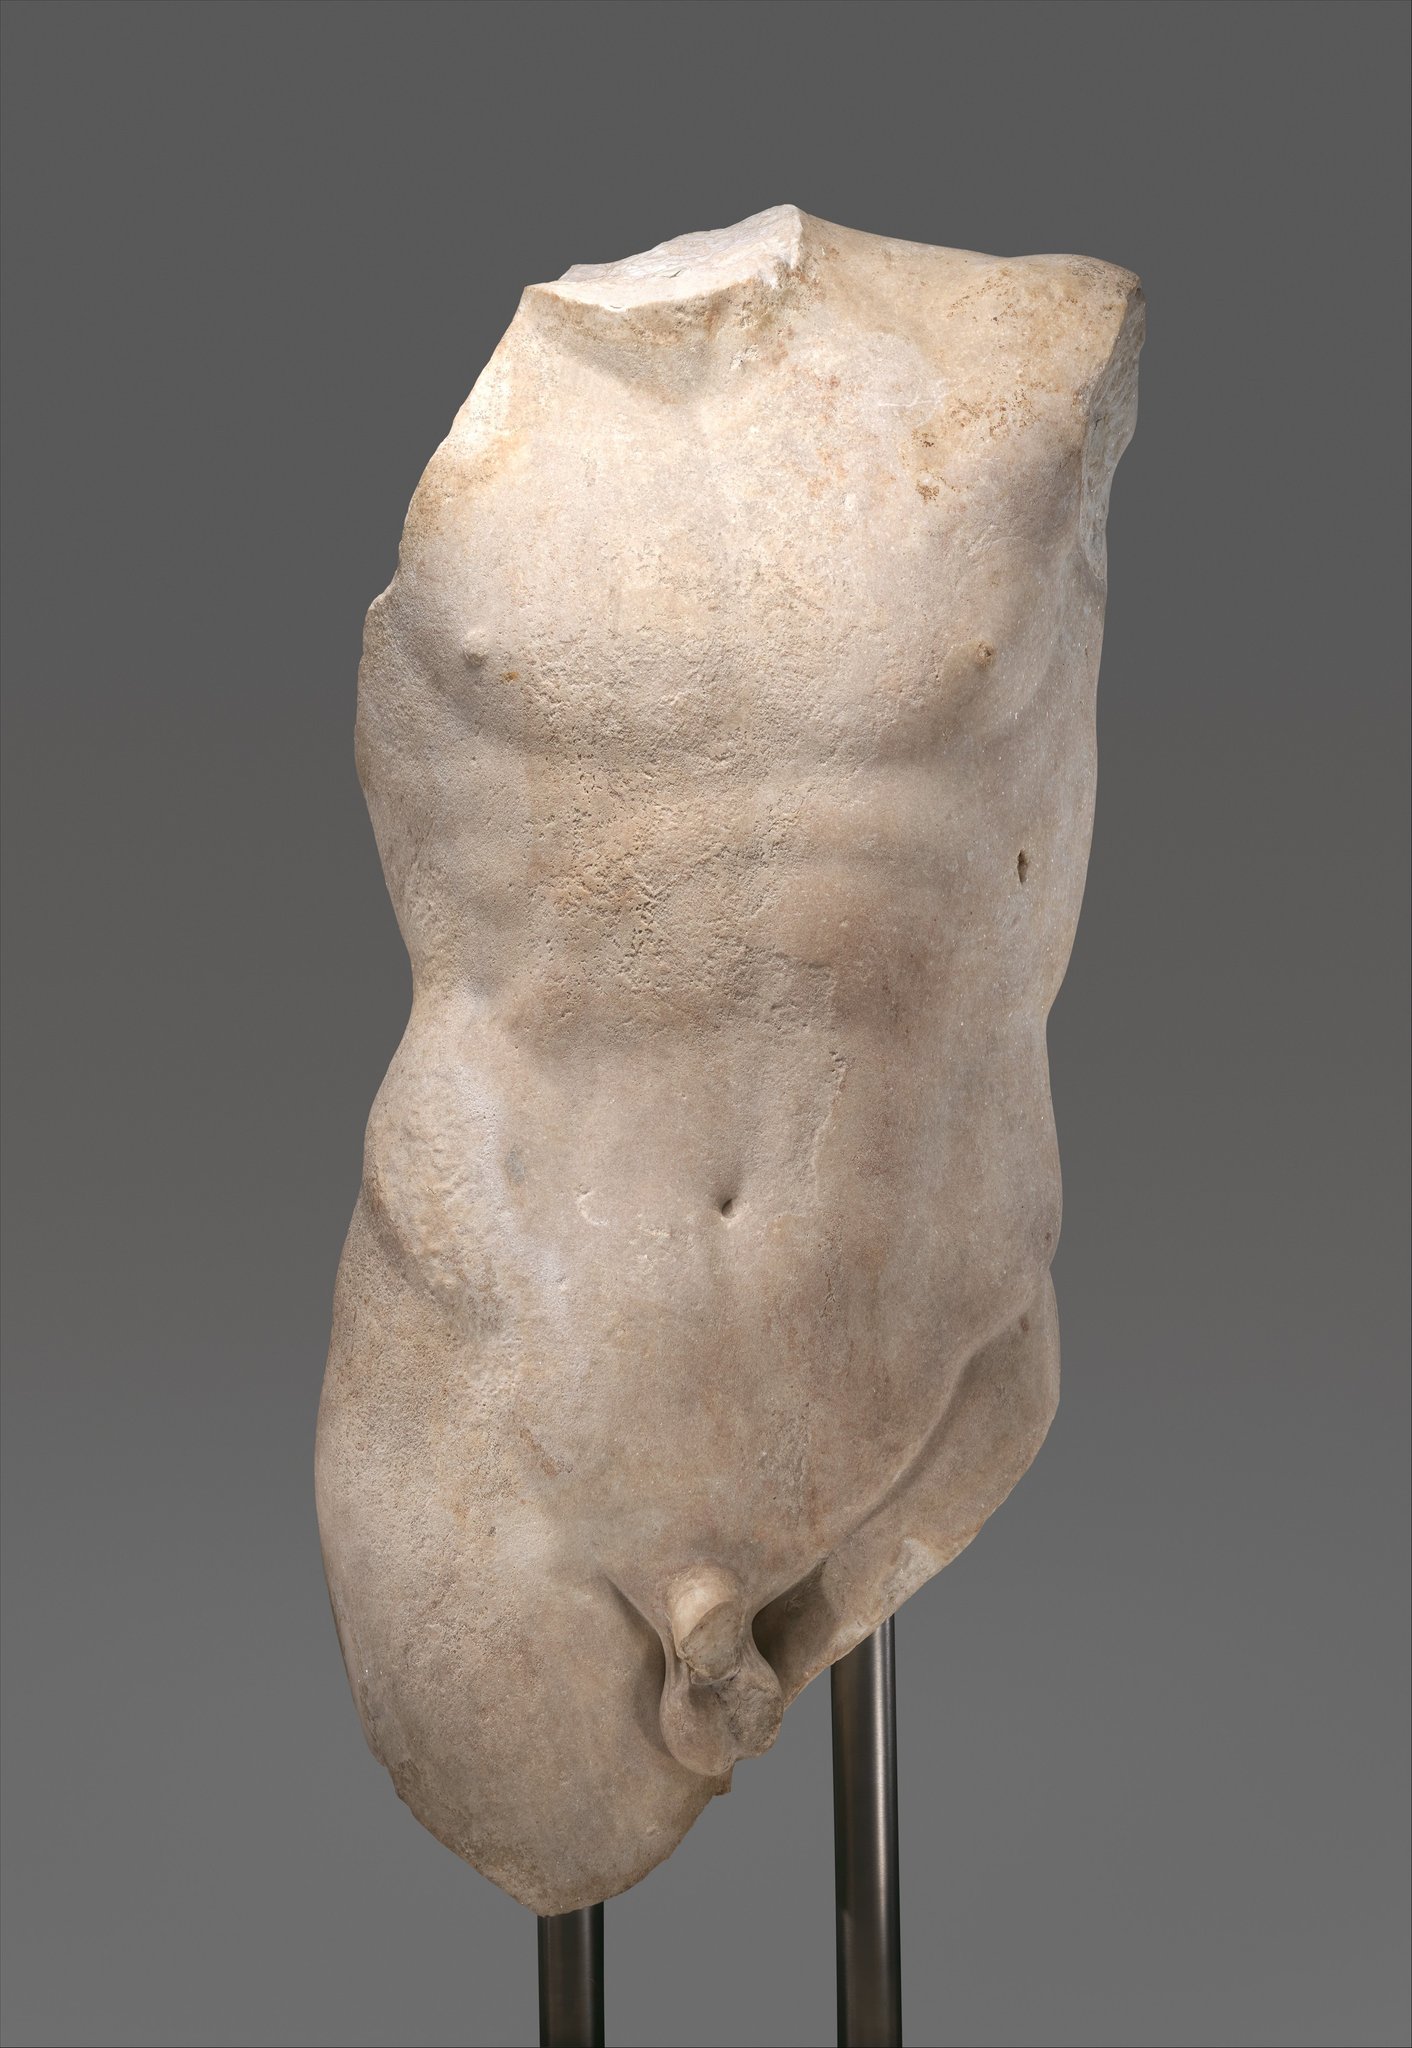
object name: statue of apollo lykeios, torso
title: Marble torso of the so-called Apollo Lykeios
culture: roman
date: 130-161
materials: marble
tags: male nudes,apollo